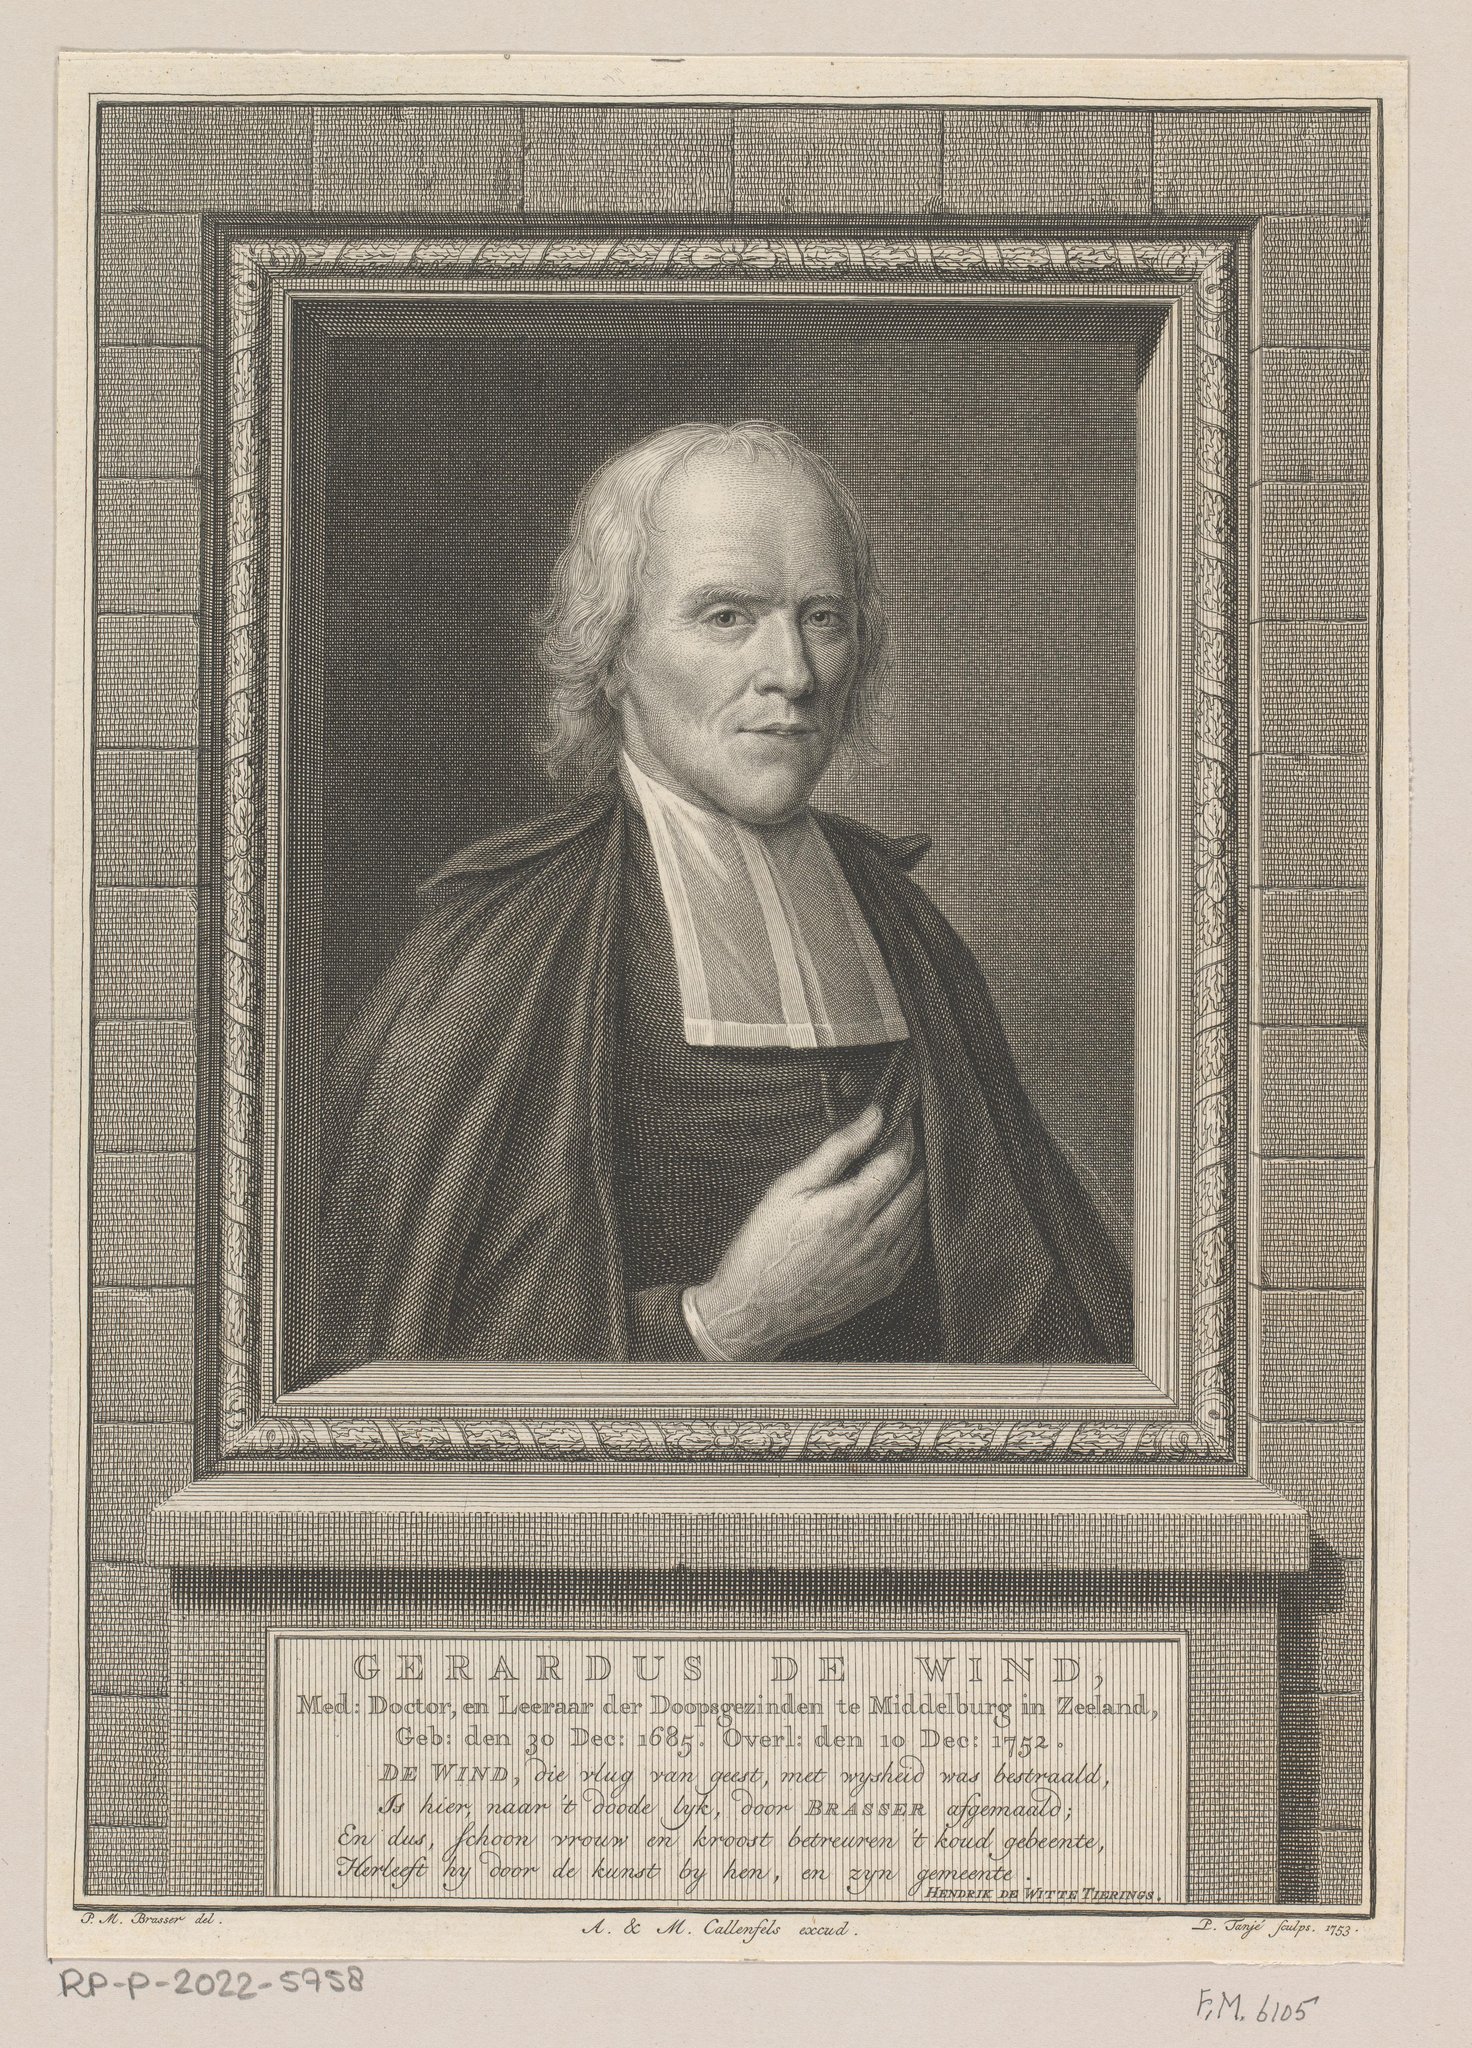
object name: print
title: Portret van Gerardus de Wind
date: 1753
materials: paper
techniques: engraving, etching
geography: middelburg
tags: middelburg, historical persons, physician, doctor (+ portrait of scholar, scientist), functionaries and dignitaries ~ protestant churches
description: Met zesregelig onderschrift in het Nederlands.